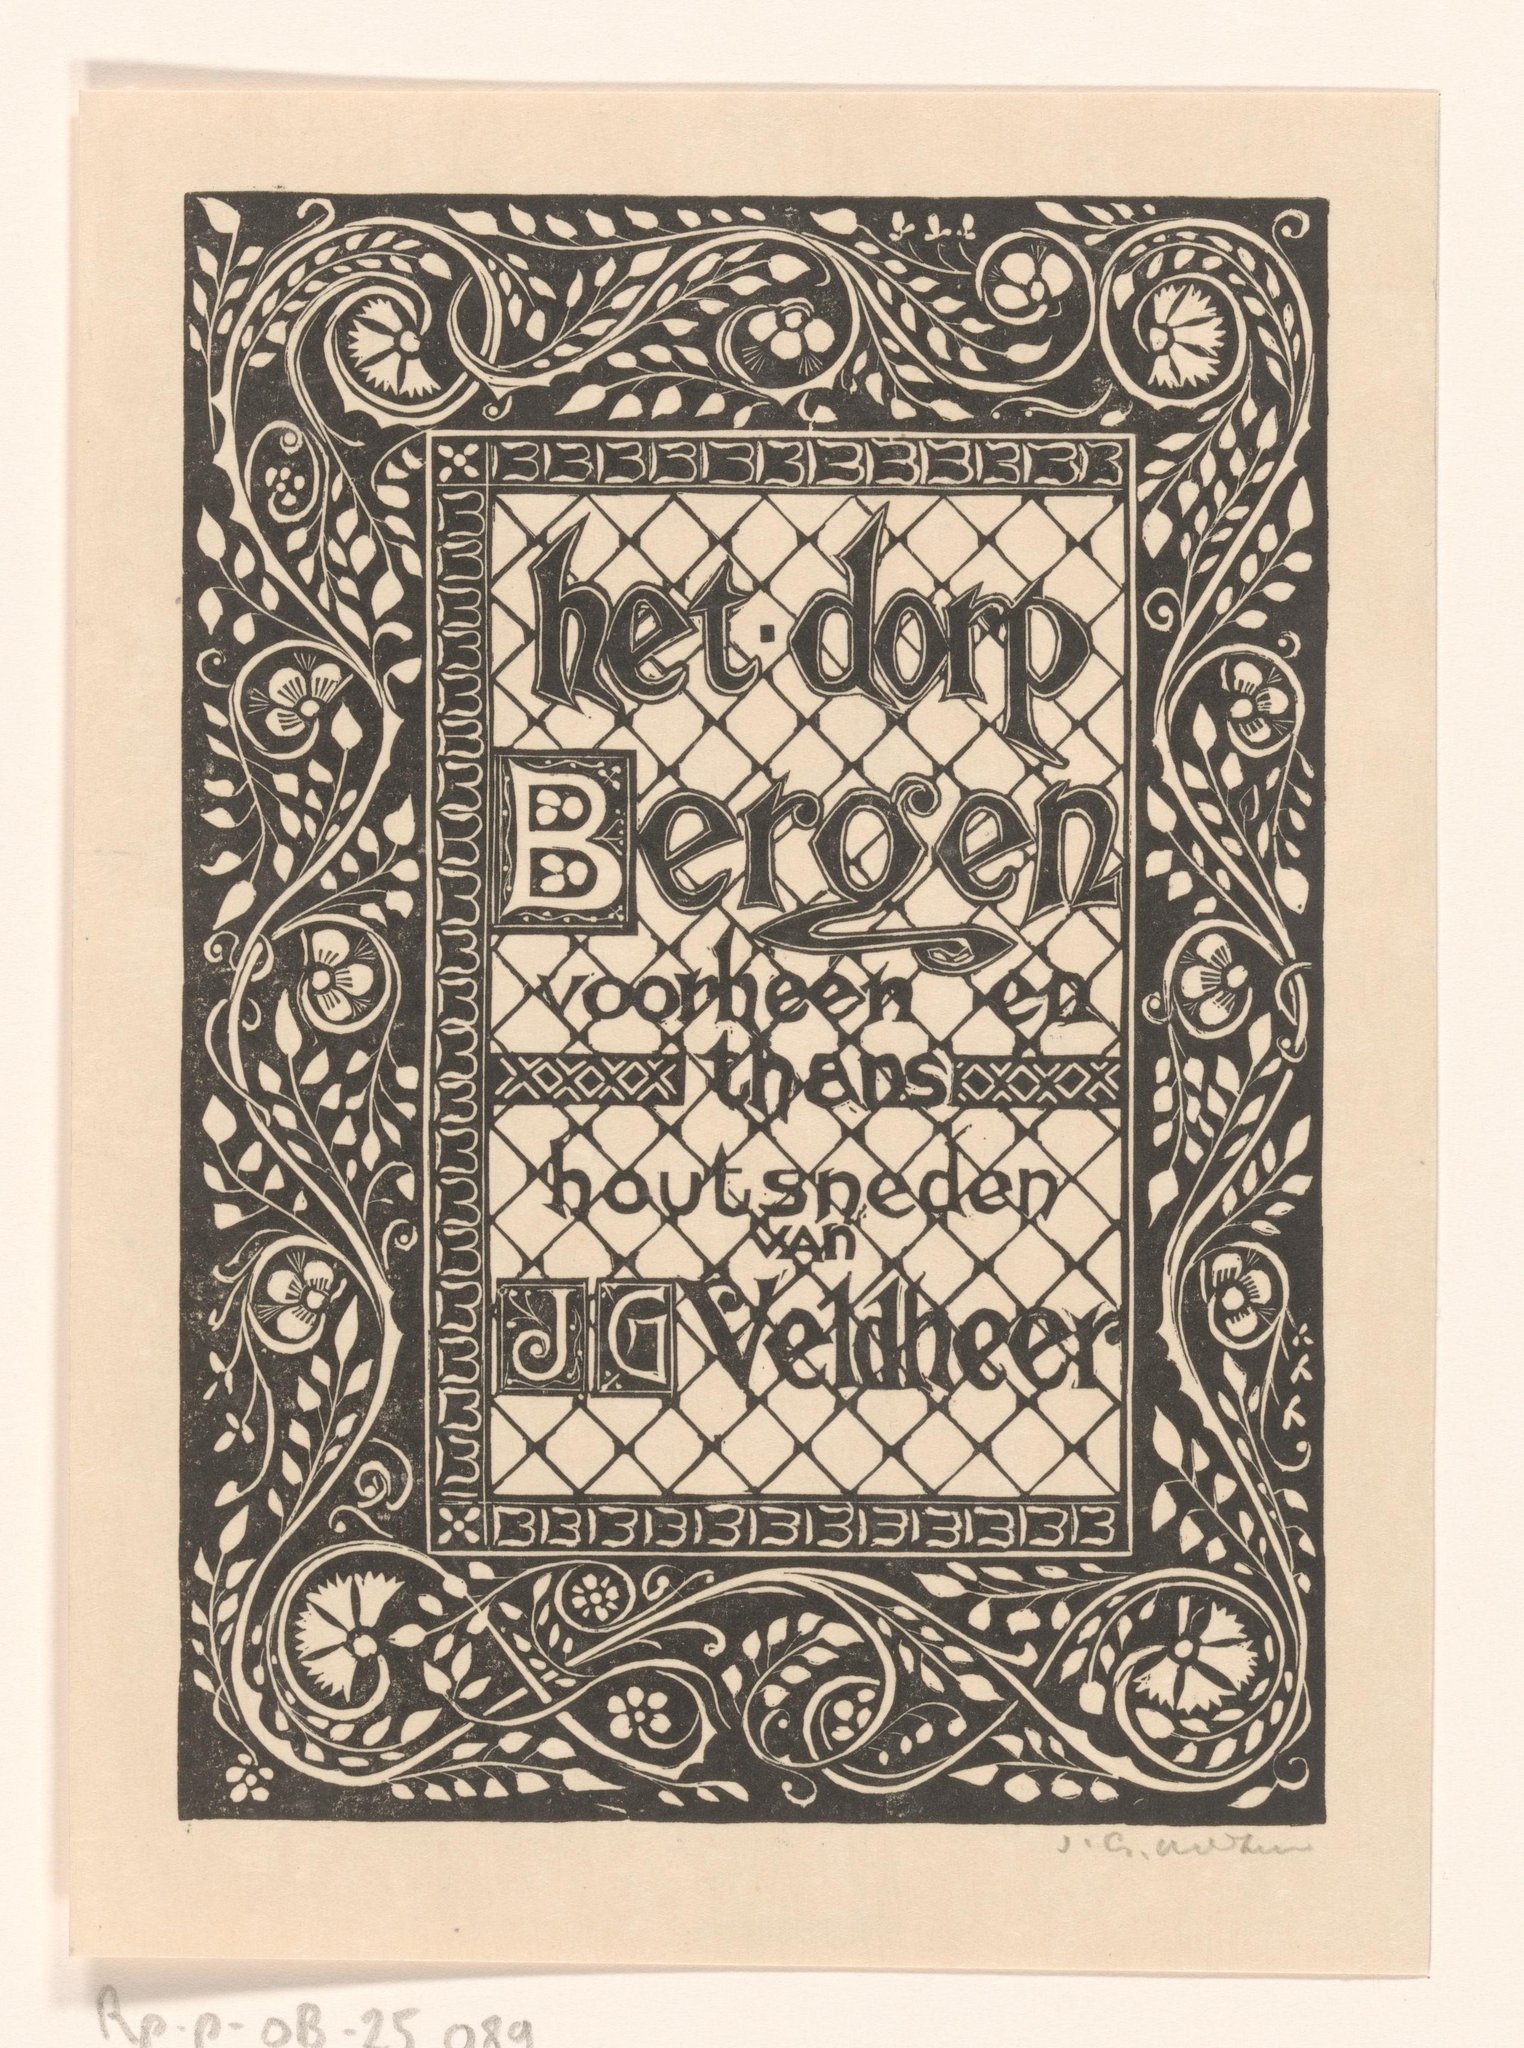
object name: titelprent, frontispice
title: Titelprent voor 'het dorp Bergen voorheen en thans'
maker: jacobus gerardus veldheer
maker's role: draughtsman, print maker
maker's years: 1866-1954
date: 1906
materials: paper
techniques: woodcut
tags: title-page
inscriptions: collector's mark: Lugt 2228